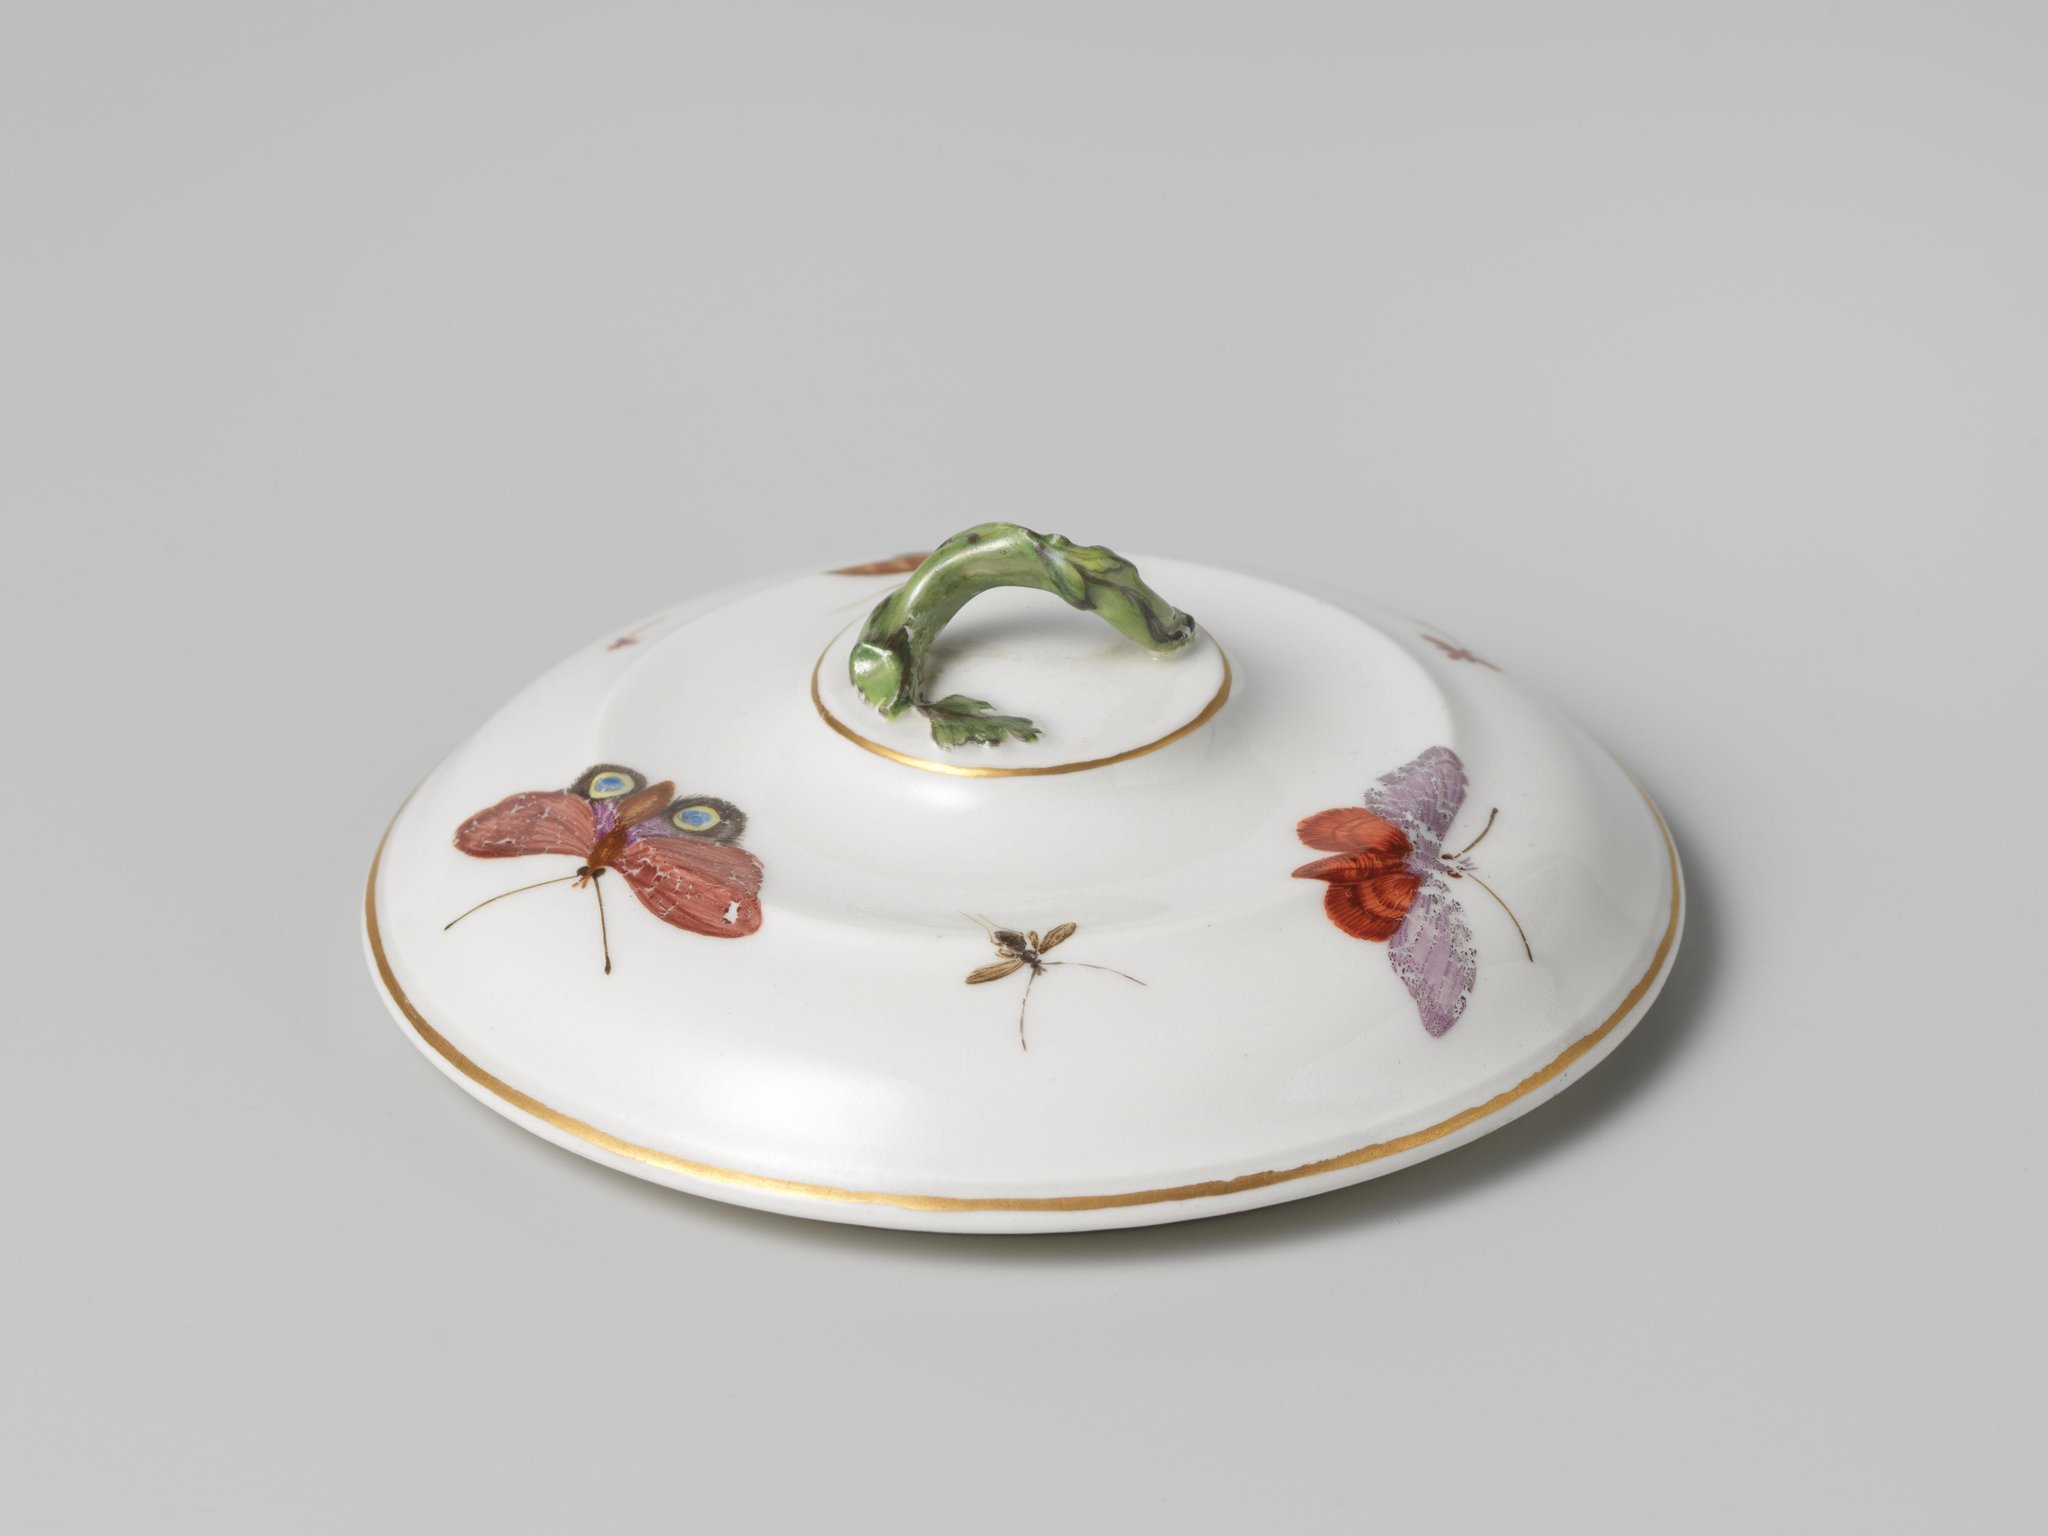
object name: lid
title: Deksel van terrine, beschilderd met vlinders en insecten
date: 1778-1782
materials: porcelain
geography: loosdrecht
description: Deksel van porselein, veelkleurig beschilderd met vlinders en insecten.